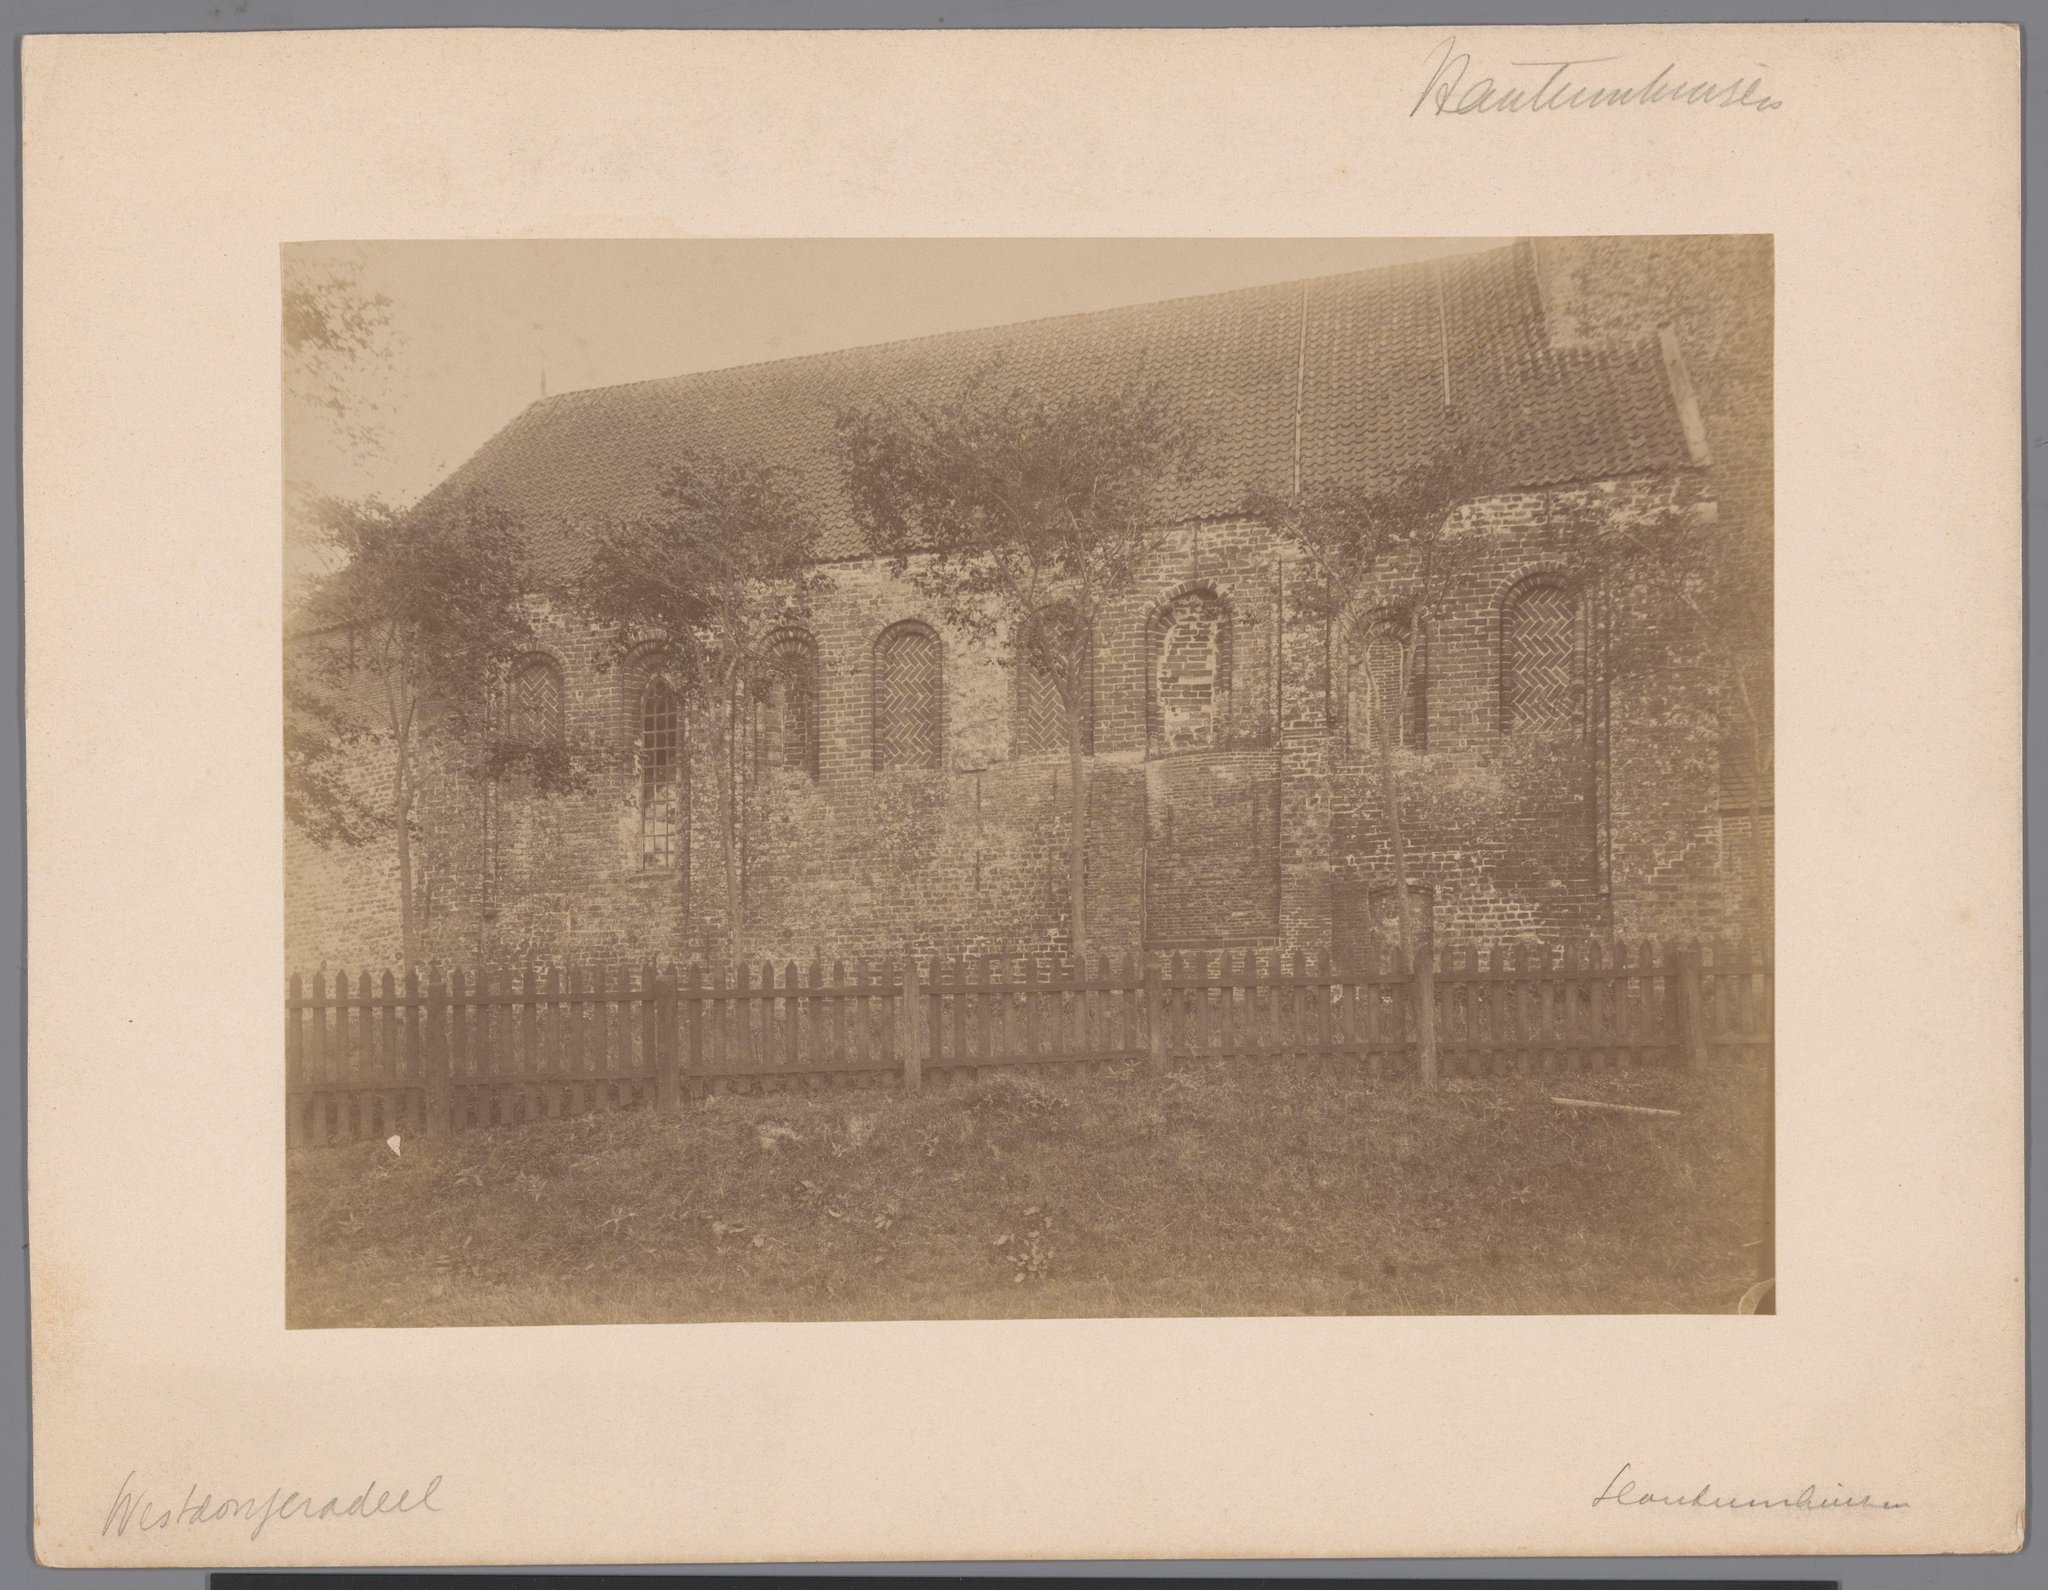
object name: photograph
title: Noordelijke gevel van de Sint-Annakerk te Hantumhuizen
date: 1900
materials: cardboard, photographic support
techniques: albumen print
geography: hantumhuizen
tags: church (exterior)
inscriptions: annotation: ‘Hantumhuizen (Fr.) / Noordelijke gevel N.H. Kerk / Augustus 1900’, annotation: ‘Westdongeradeel/ Hantumhuizen/ Hantumhuisen’